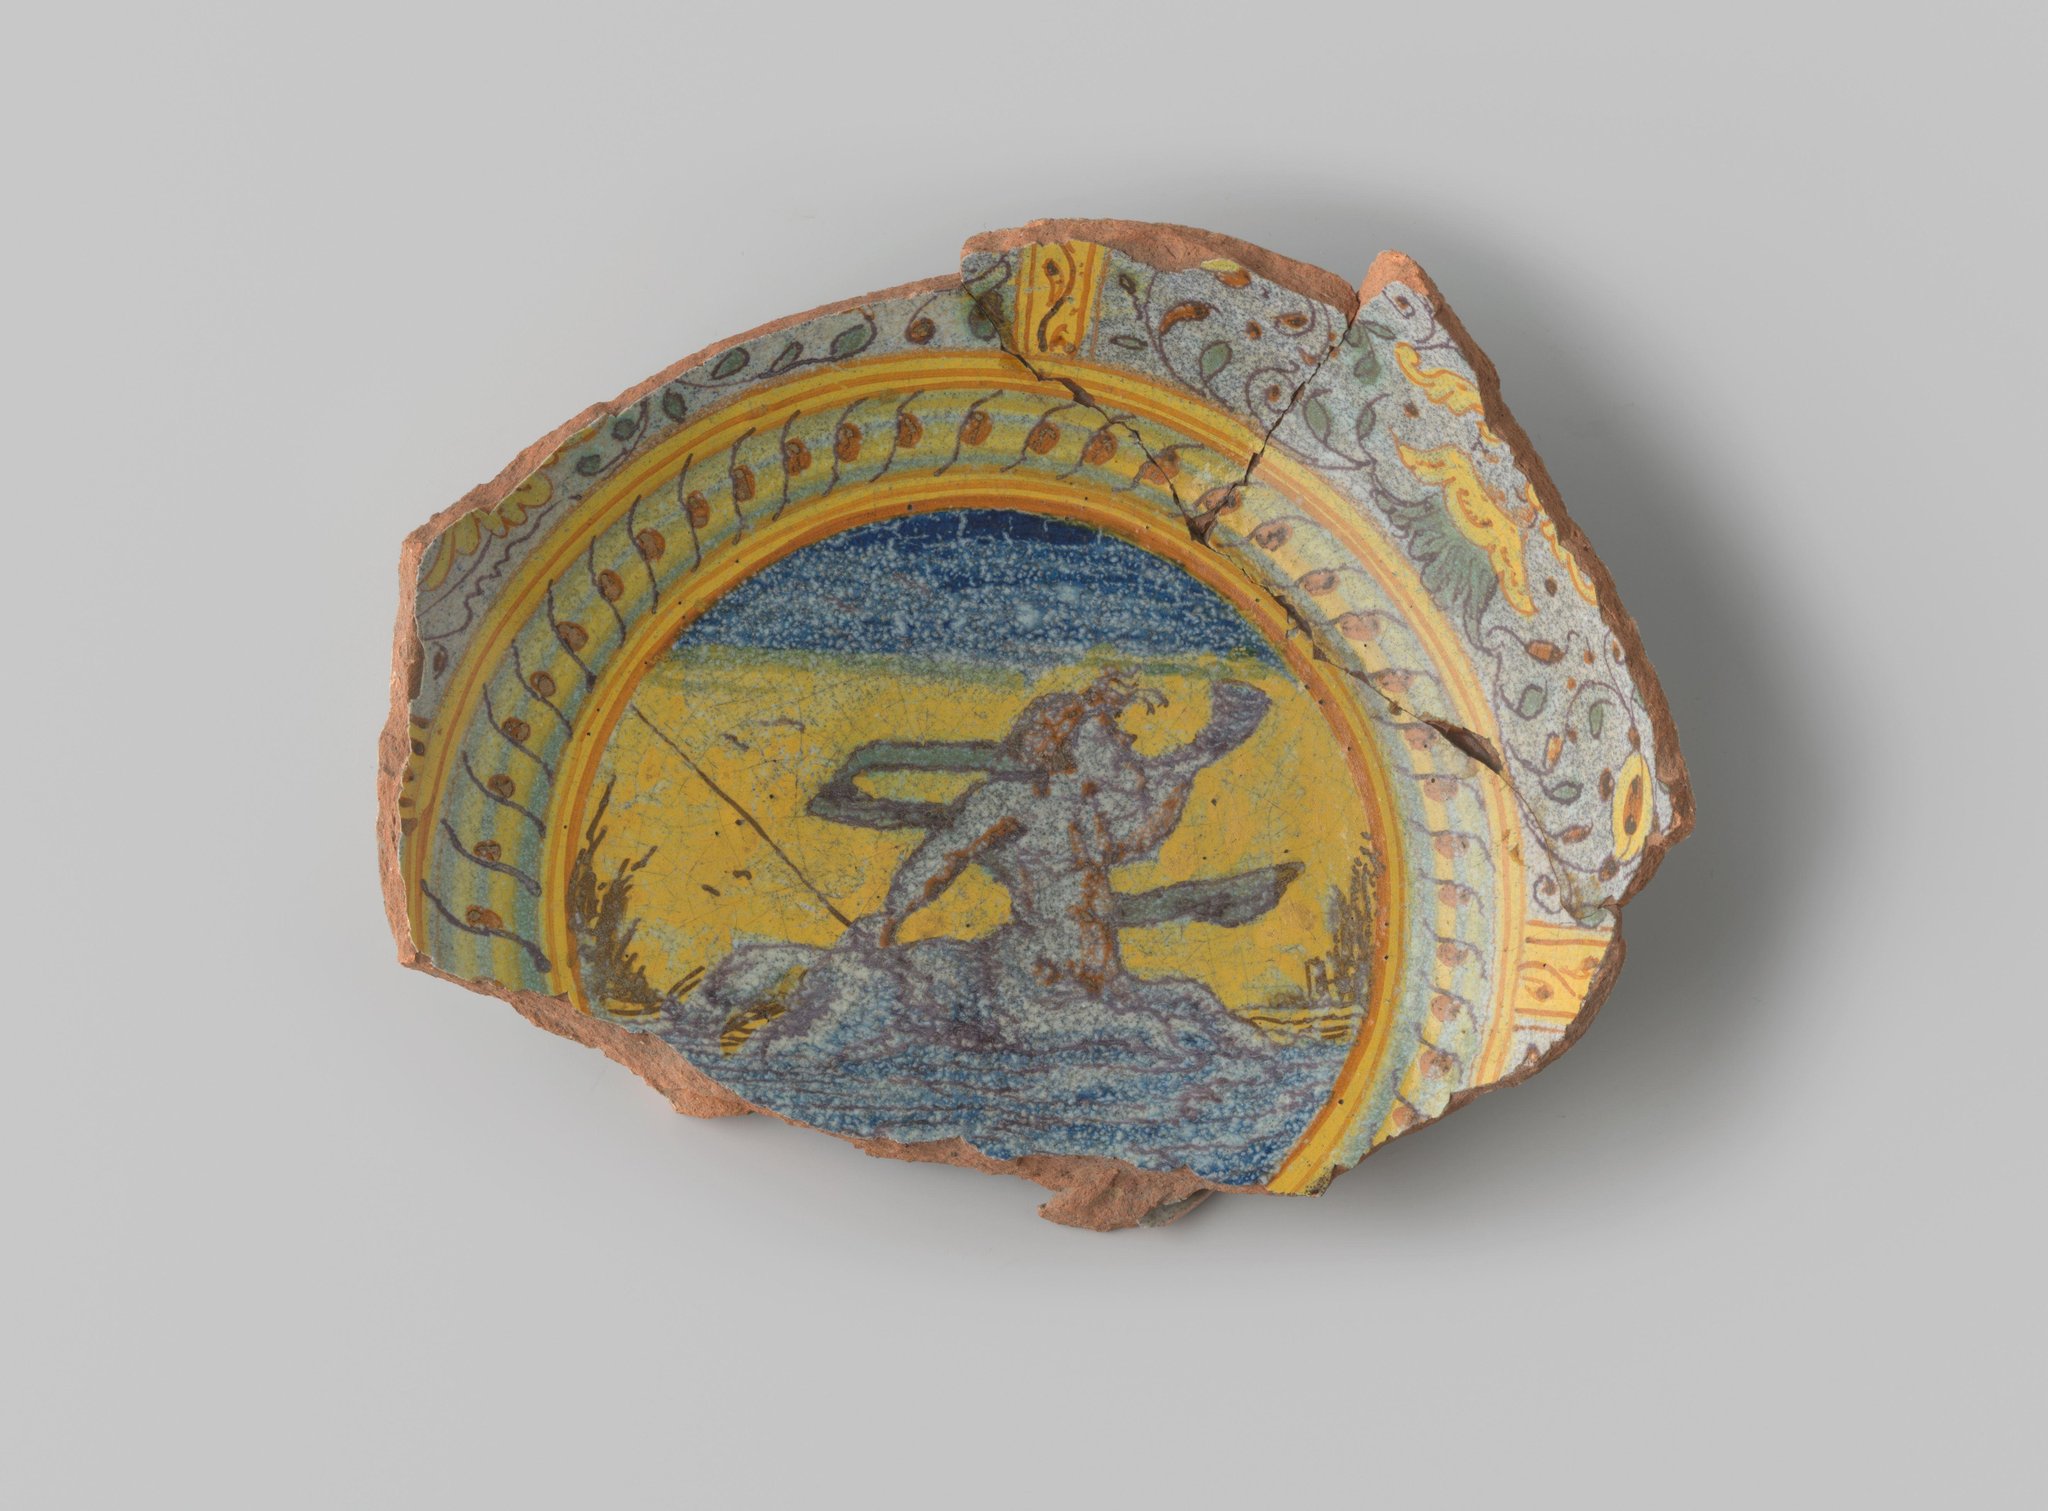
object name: fragment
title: Schotelscherf van roodbakkend aardewerk, met voetring, voorzien van een schildering op het plat, van een mythologische figuur in het water staand, omcirkeld met verschillende randen en bloemvormen in geel, groen, oranje, bruin en blauw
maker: Anonymous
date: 1600-1650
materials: earthenware, glaze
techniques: maiolica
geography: northern netherlands